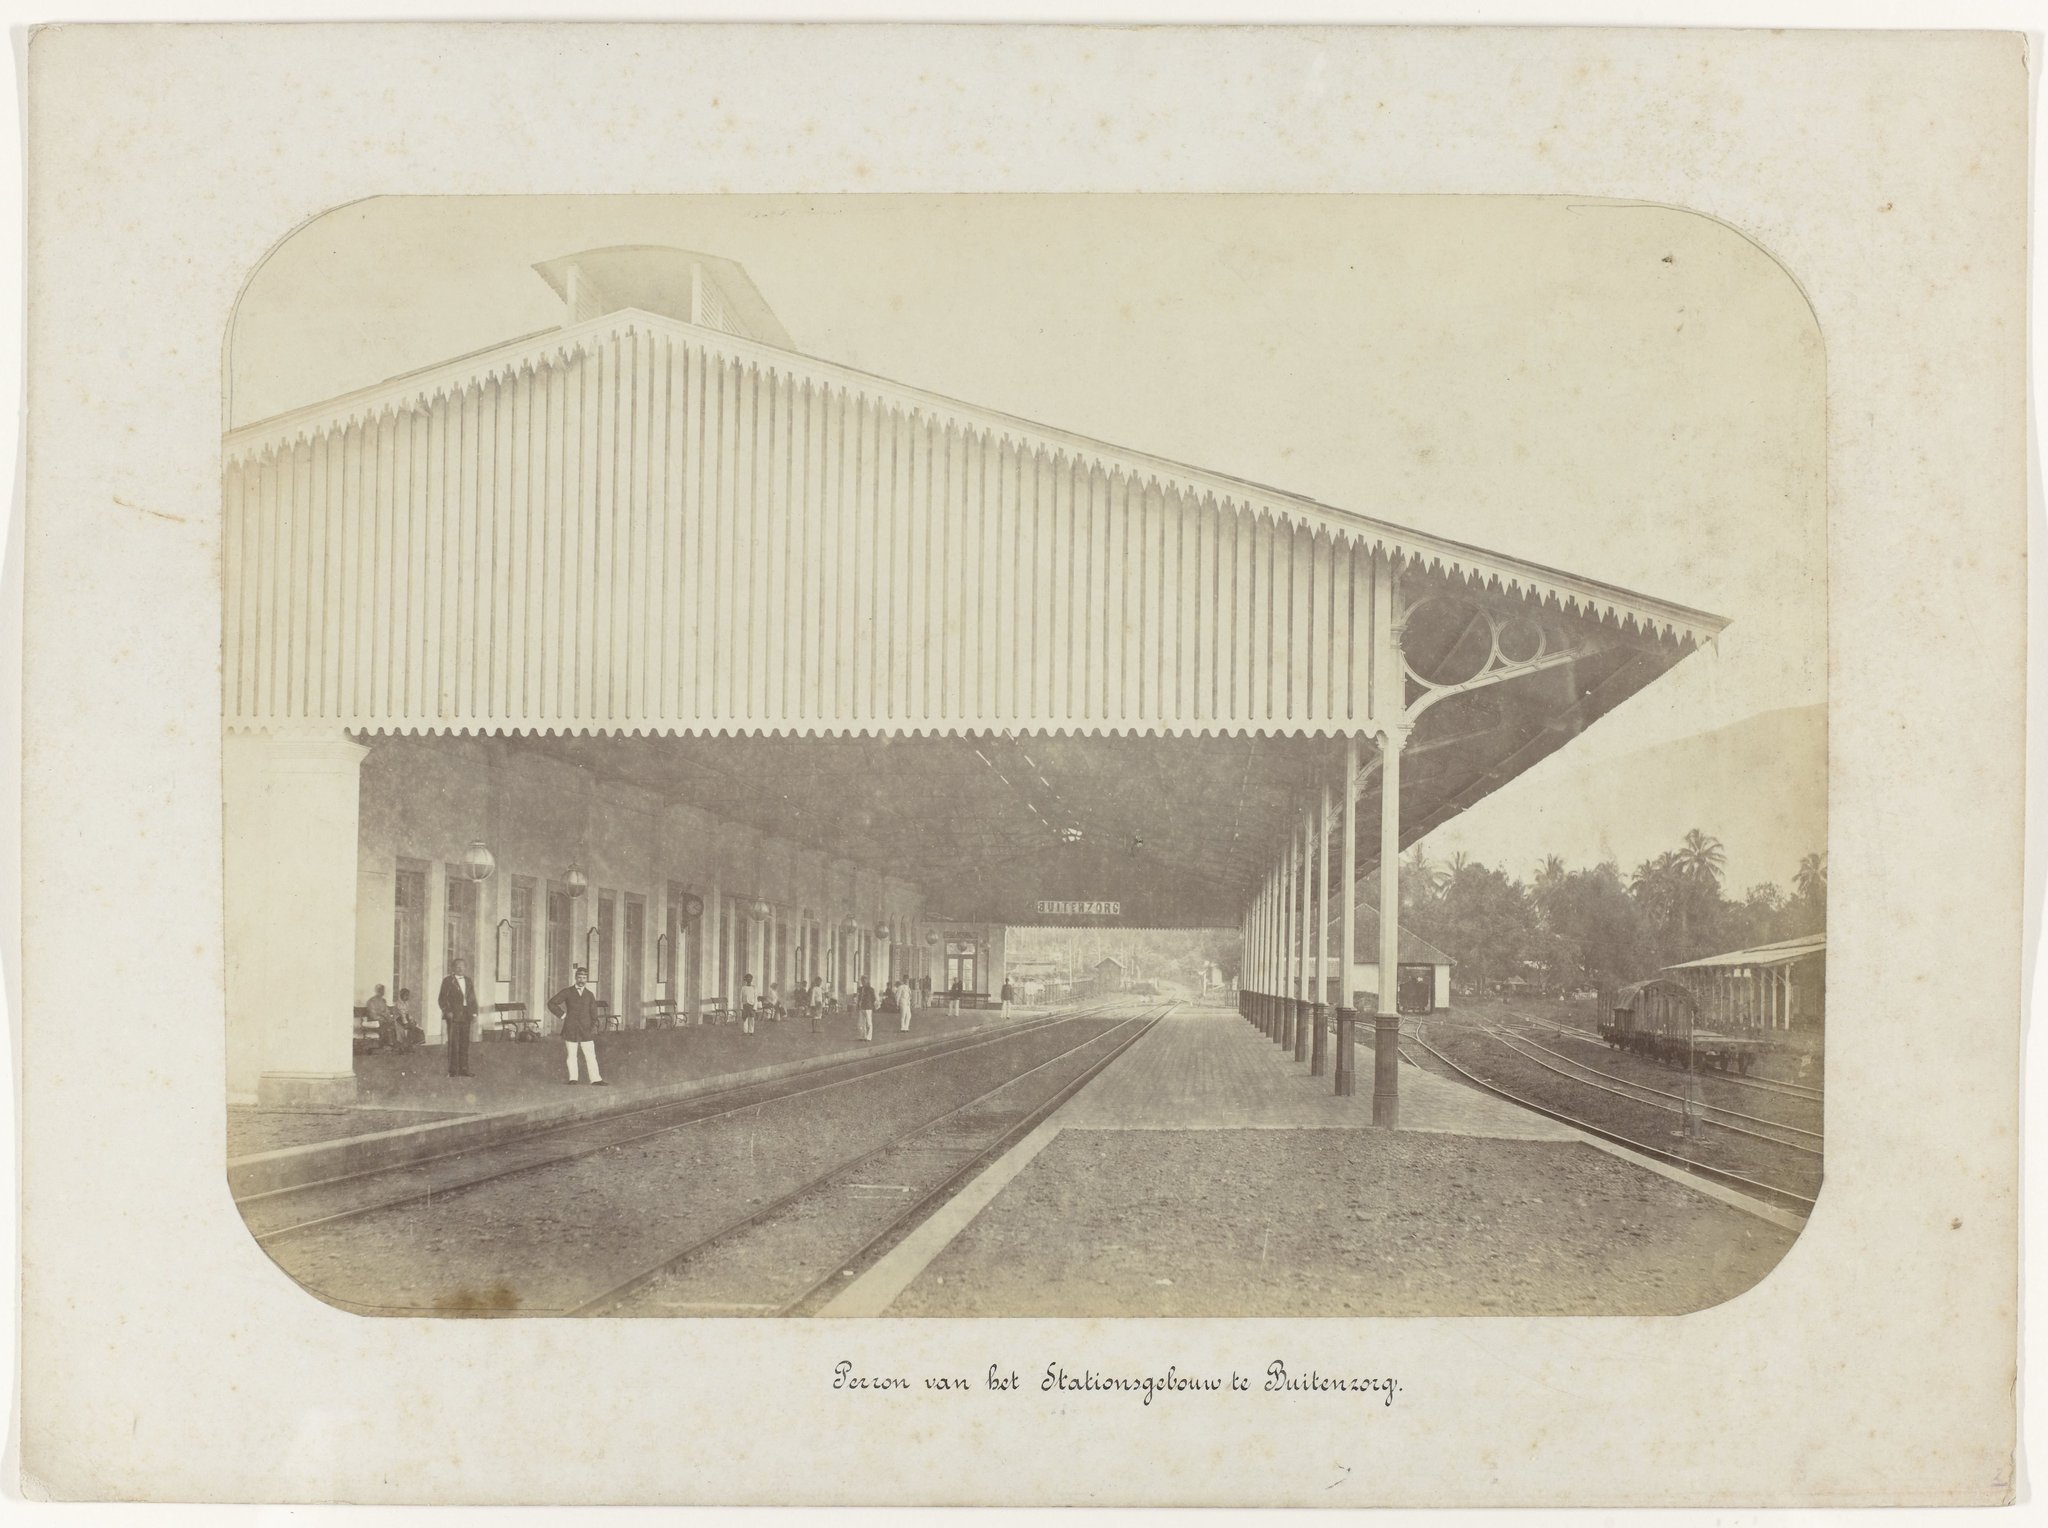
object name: photograph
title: Perron van het stationsgebouw te Buitenzorg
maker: Anonymous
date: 1880-1888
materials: photographic support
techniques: albumen print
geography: java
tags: buitenzorg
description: Het perron van het stationsgebouw te Buitenzorg. Onderdeel van een groep van 62 foto's in een doos met het opschrift "Staatsspoorwegen op Java" uit 1888.